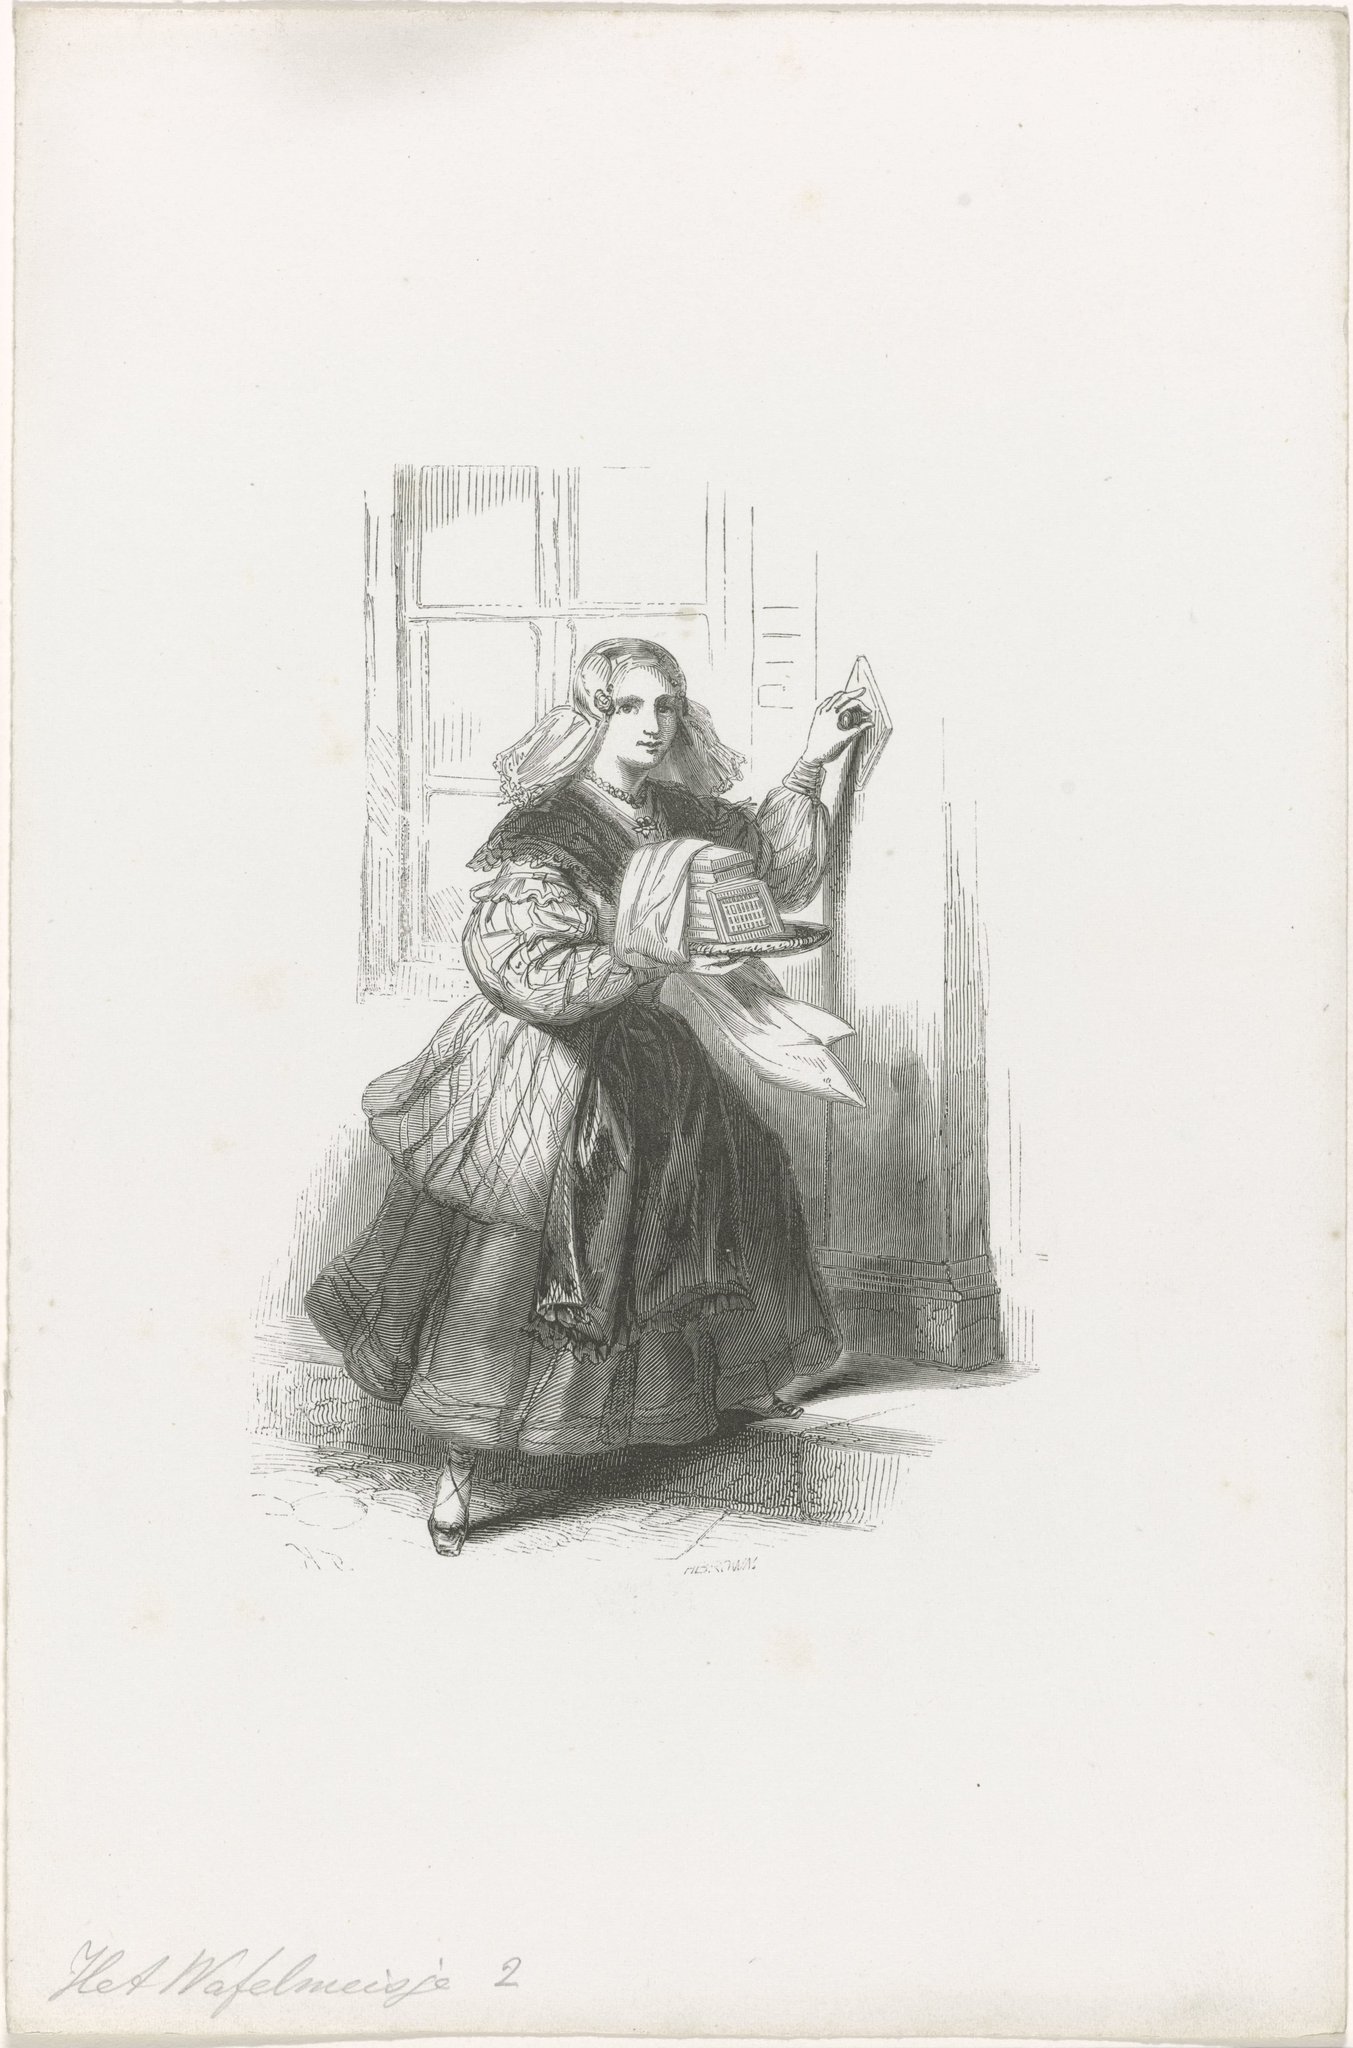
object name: print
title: Het wafelmeisje, 1840-1841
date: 1840-1841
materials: paper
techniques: engraving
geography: netherlands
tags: professional clothes, wandering or travelling merchant - bb - women engaged in trade and commerce, waffles, netherlands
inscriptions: collector's mark: Lugt 2228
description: Gebruikt als illustratie in: De Nederlanden : karakterschetsen, kleederdrachten, houding en voorkomen van verschillende standen : tekst van de meest geachte schrijvers : met gravuren van Henry Brown naar teekeningen van de voornaamste Nederlandsche kunstenaars. 's Gravenhage, 1841.